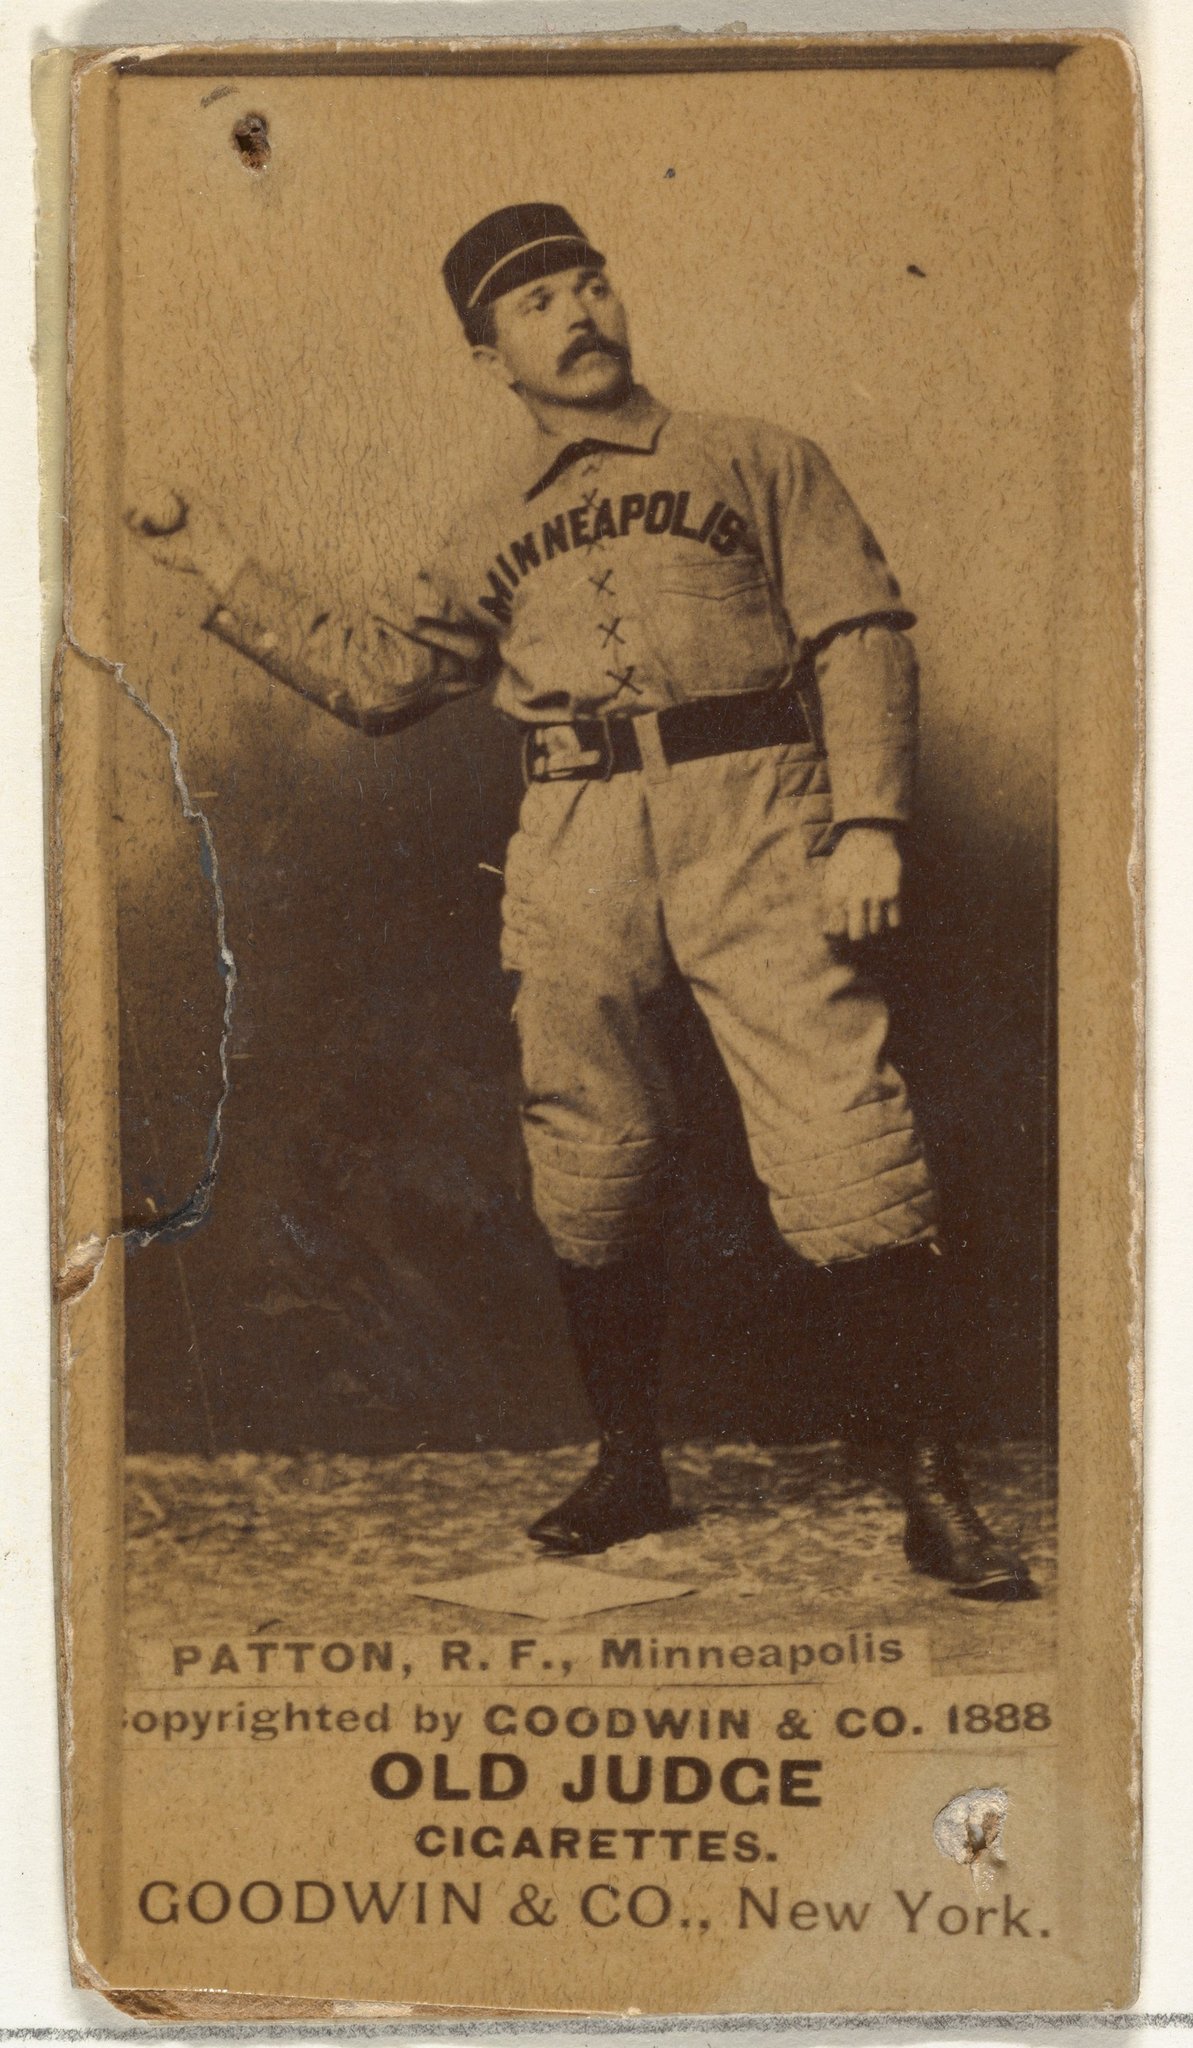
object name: baseball card, photograph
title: Owen Joseph Patton, Right Field, Minneapolis, from the Old Judge series (N172) for Old Judge Cigarettes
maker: goodwin & company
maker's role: publisher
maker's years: 1850-1950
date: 1888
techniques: albumen silver print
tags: men,portraits,baseball,athletes